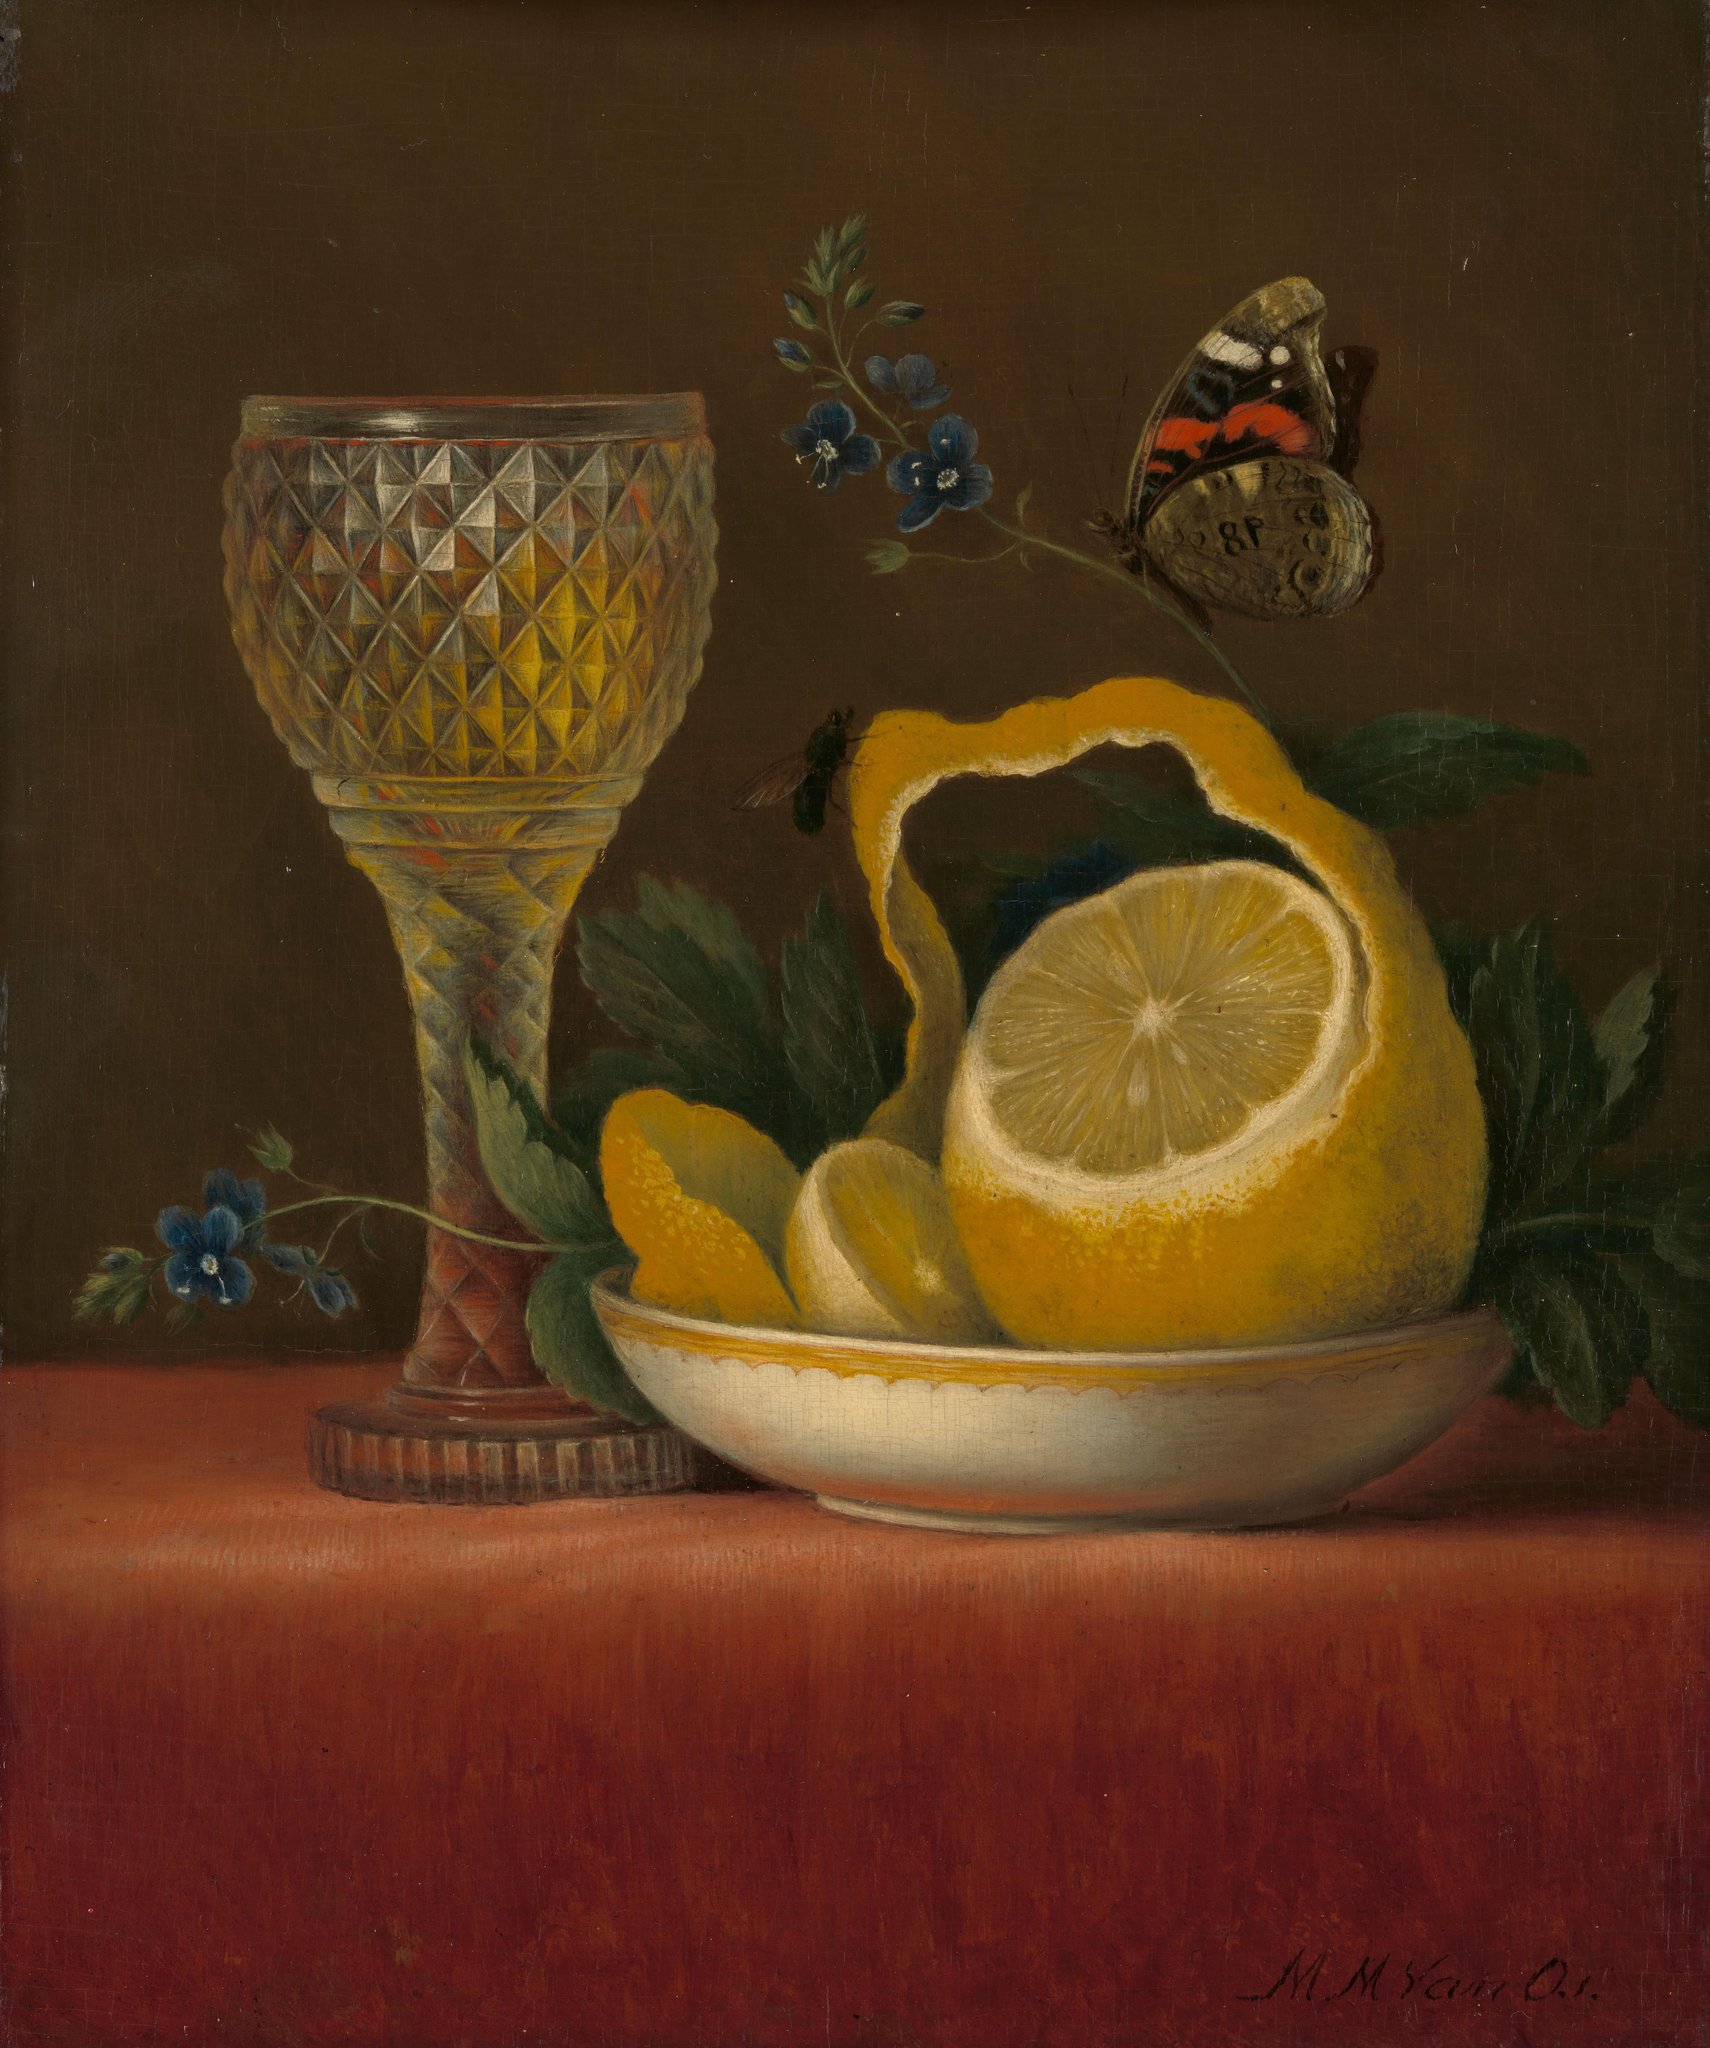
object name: painting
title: Still Life with Lemon and Cut Glass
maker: maria margaretha van os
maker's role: draughtsman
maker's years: 1780-1862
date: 1823-1826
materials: oil, panel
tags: insects: butterfly, poor kitchen, fruits: lemon, still life of miscellaneous objects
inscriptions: signature: ‘M.M. van Os’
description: Stilleven met een geschilde citroen in een kommetje, een geslepen glas en een bloementakje met een vlinder.